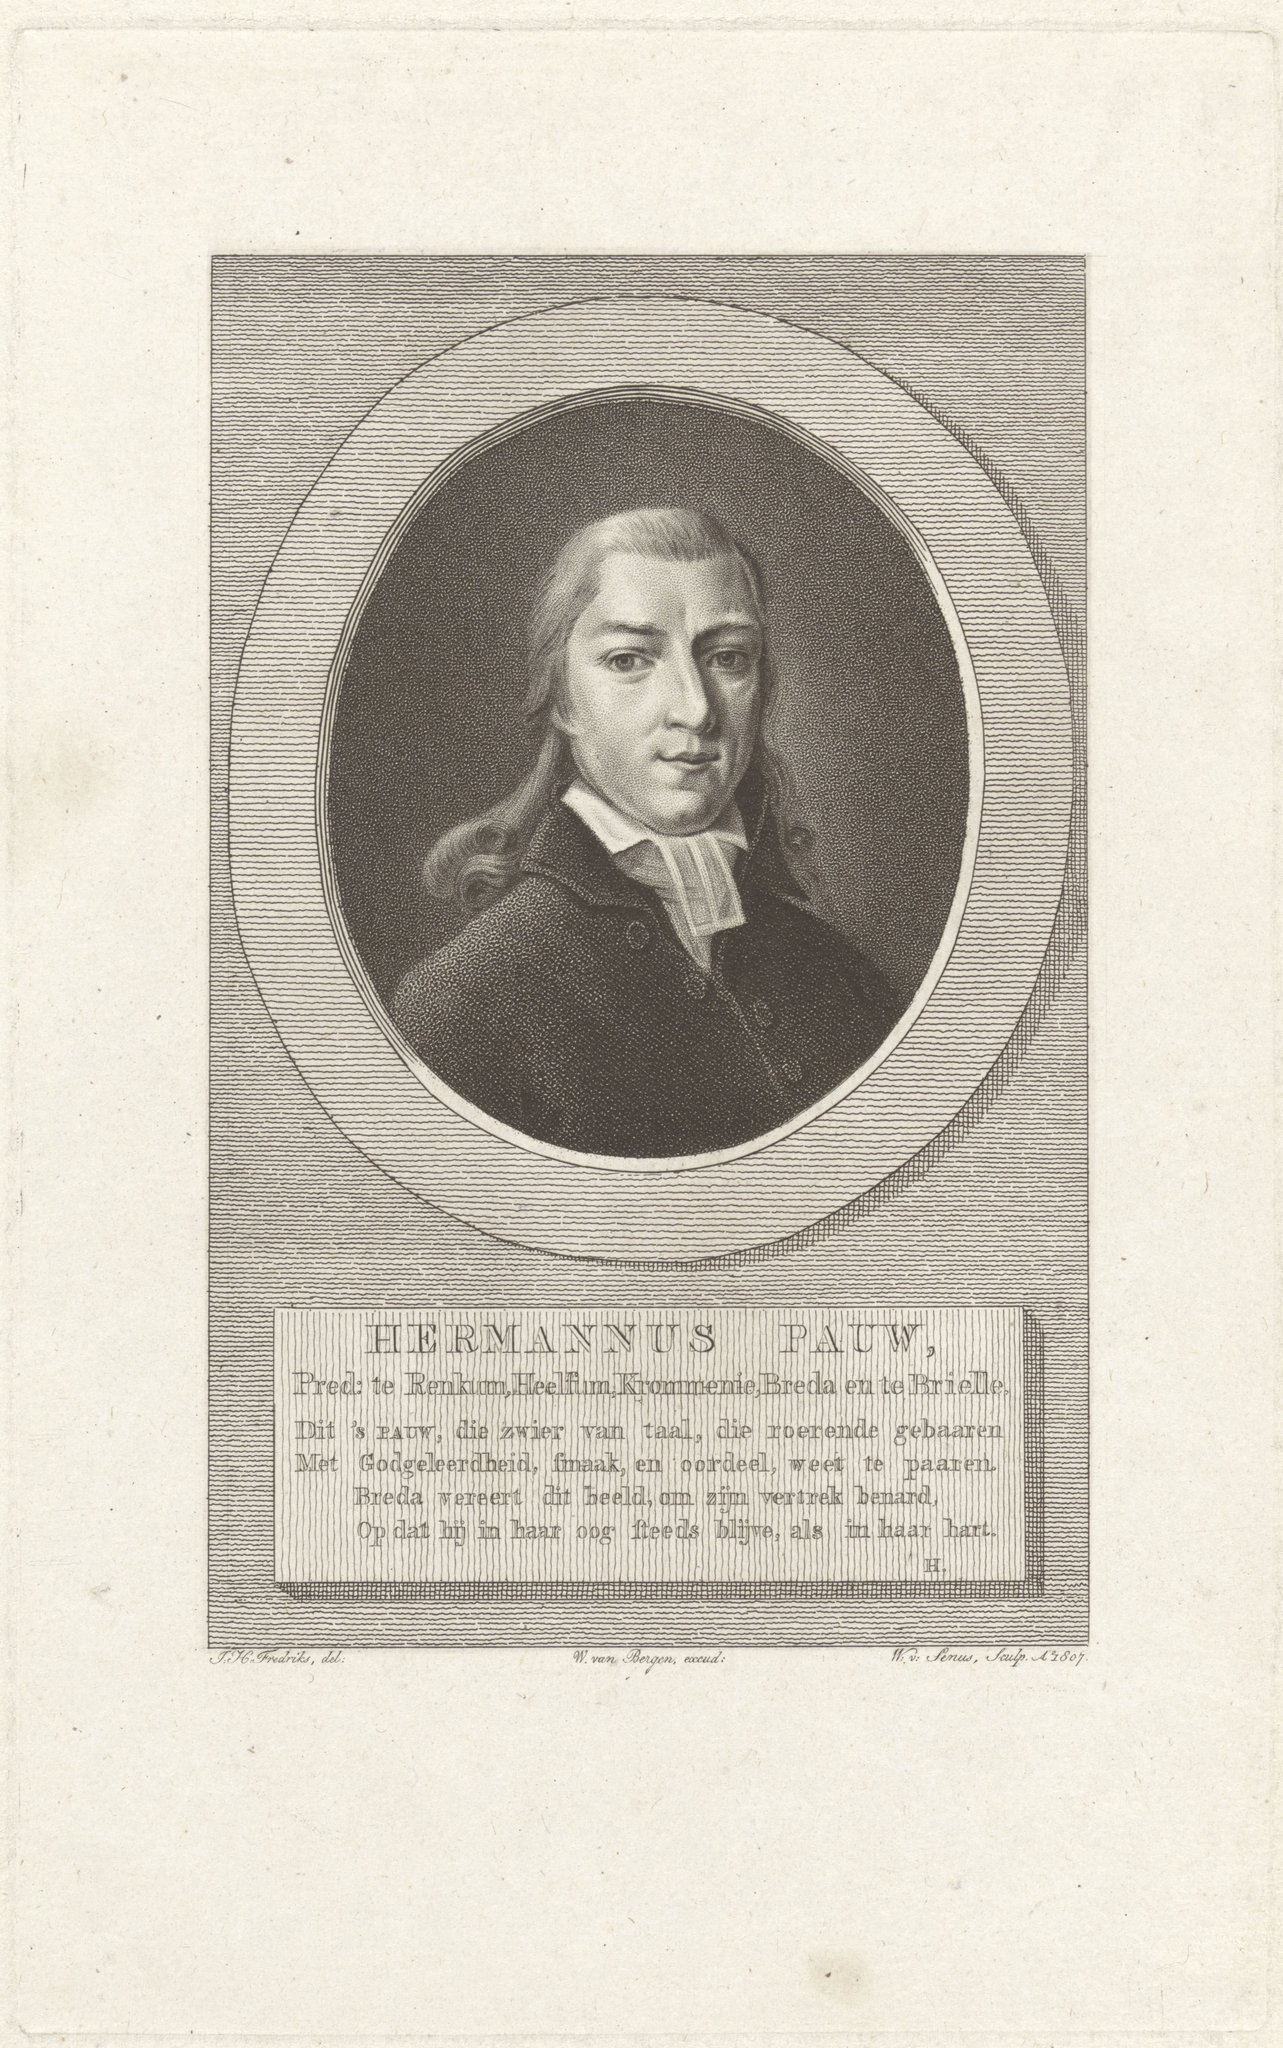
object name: print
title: Portret van Hermannus Pauw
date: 1807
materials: paper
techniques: engraving, etching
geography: netherlands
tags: utrecht, hermannus pauw, historical persons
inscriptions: collector's mark: Lugt 2228